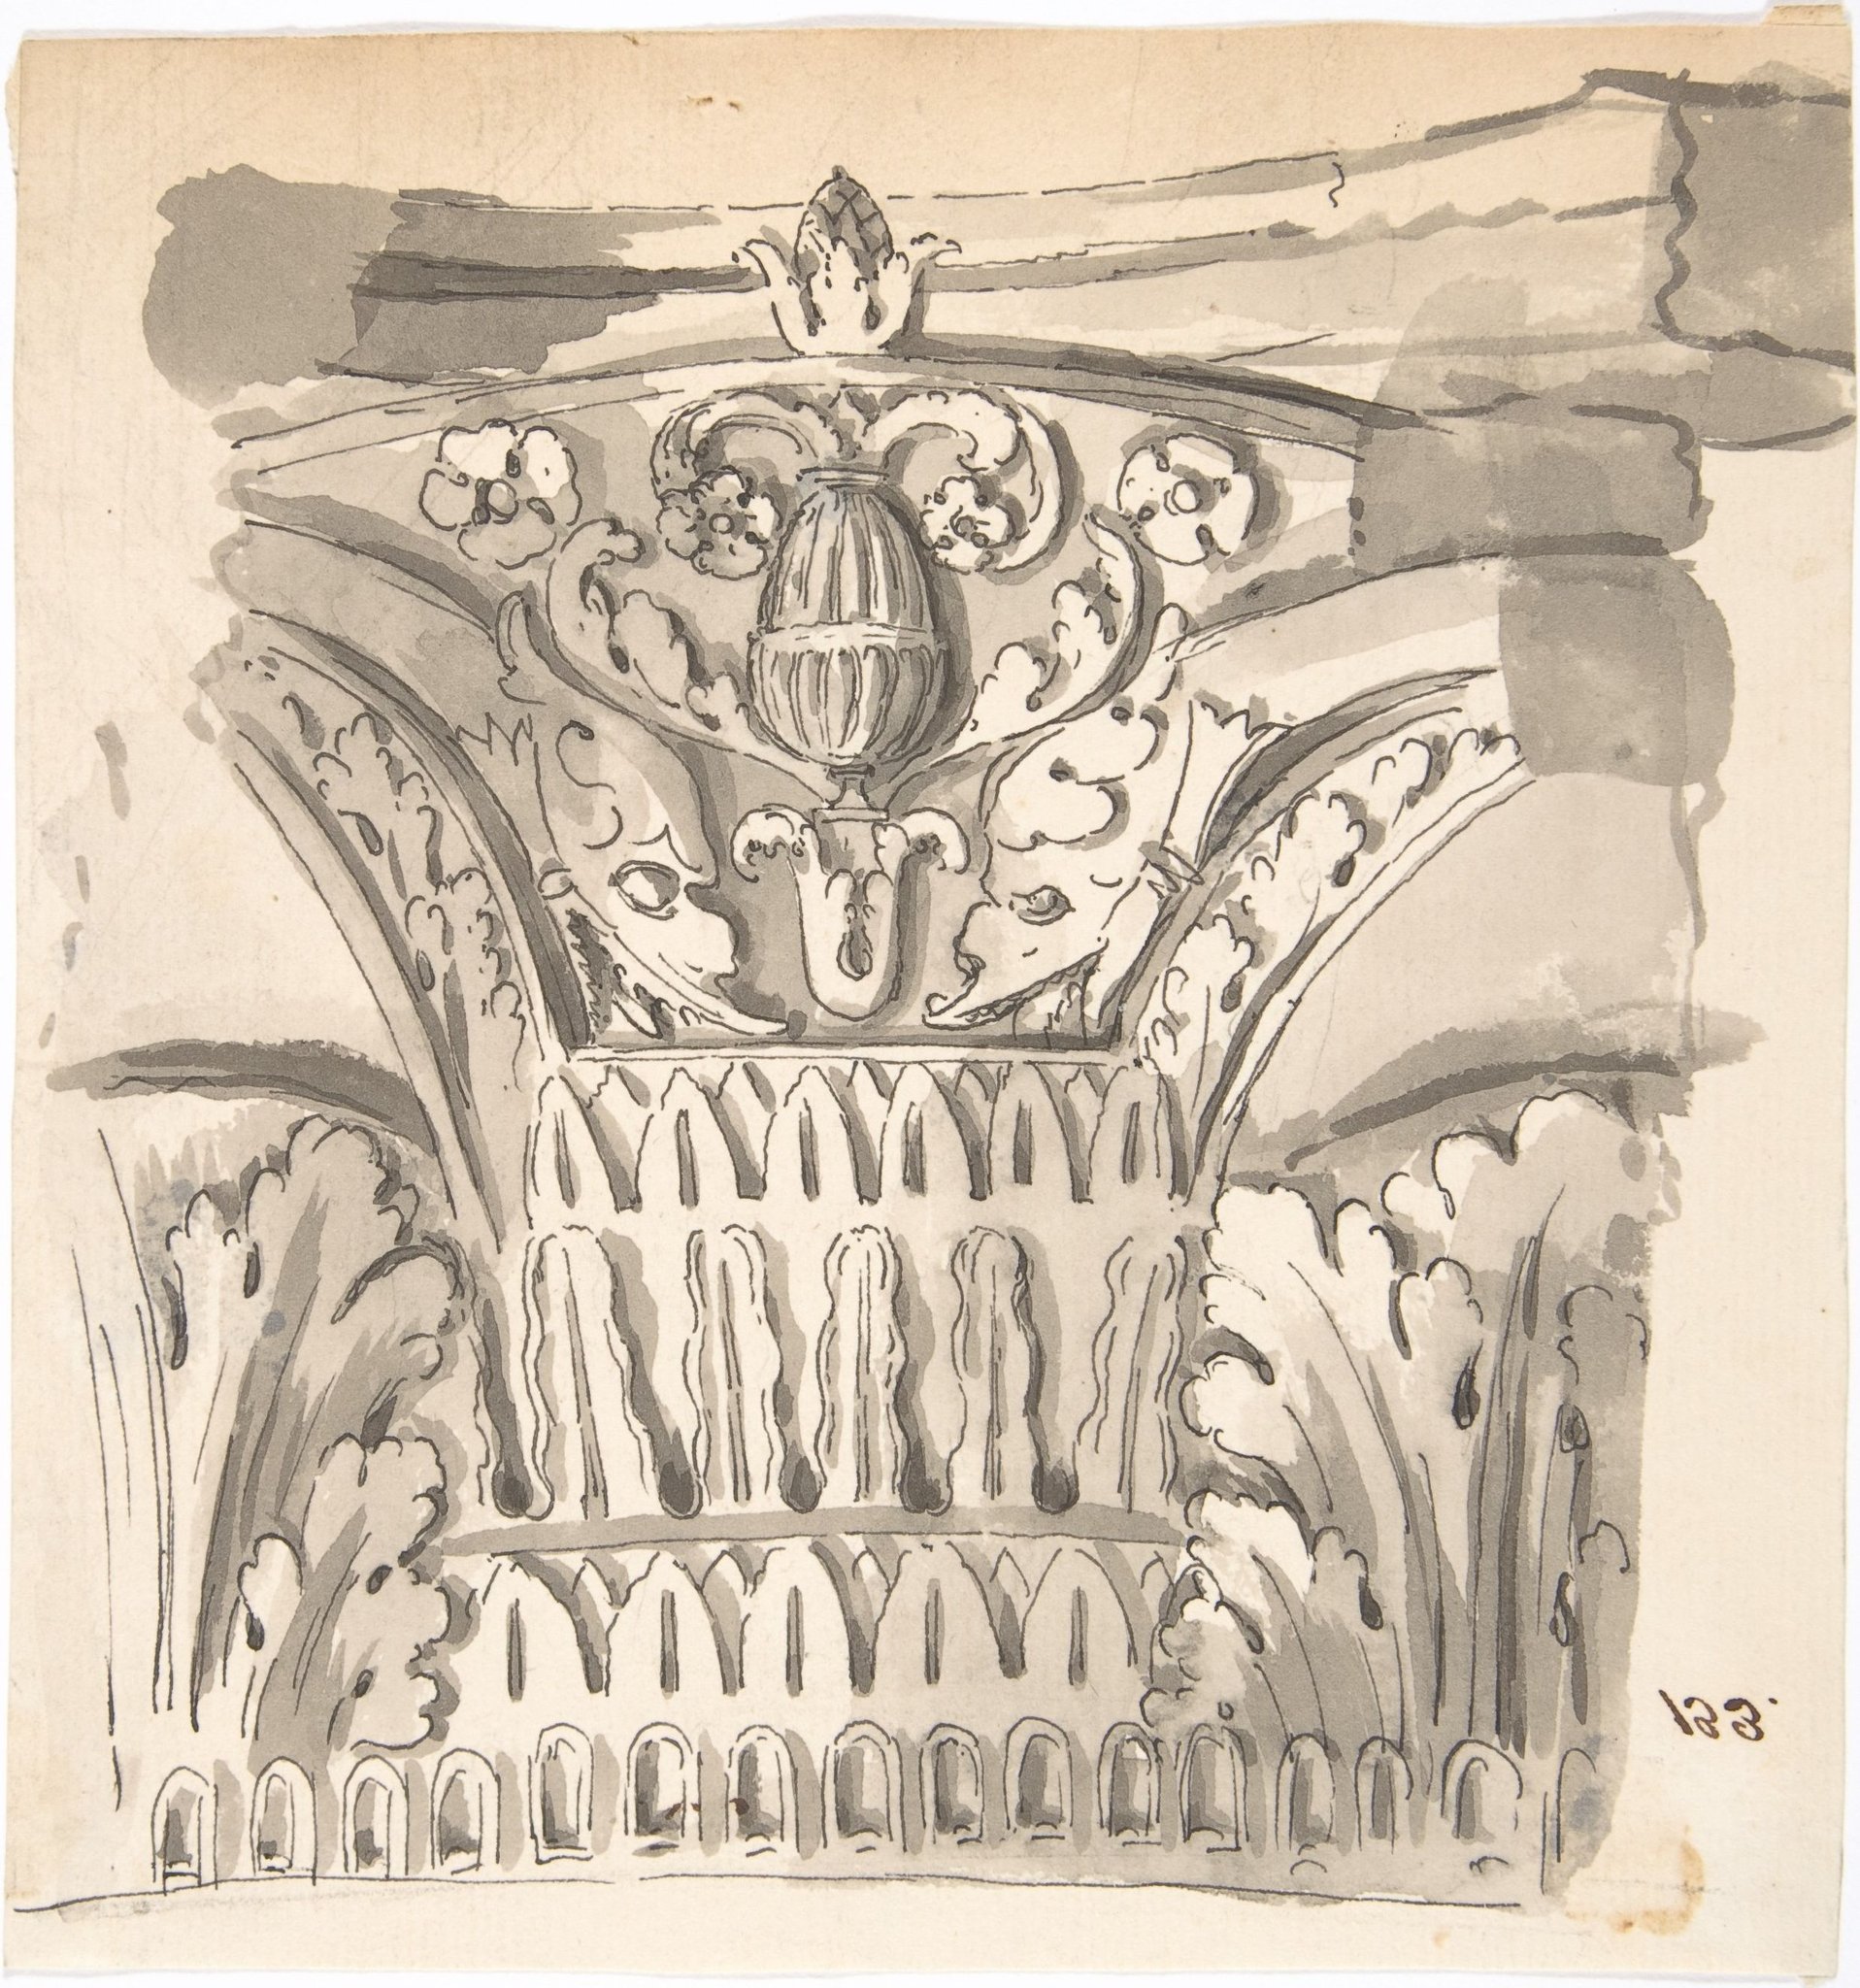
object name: drawing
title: Fragment of a Capital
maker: anonymous, french, 18th century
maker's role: artist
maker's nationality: french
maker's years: 1700-1800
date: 1701-1800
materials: ink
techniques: brush, pen, wash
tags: capitals